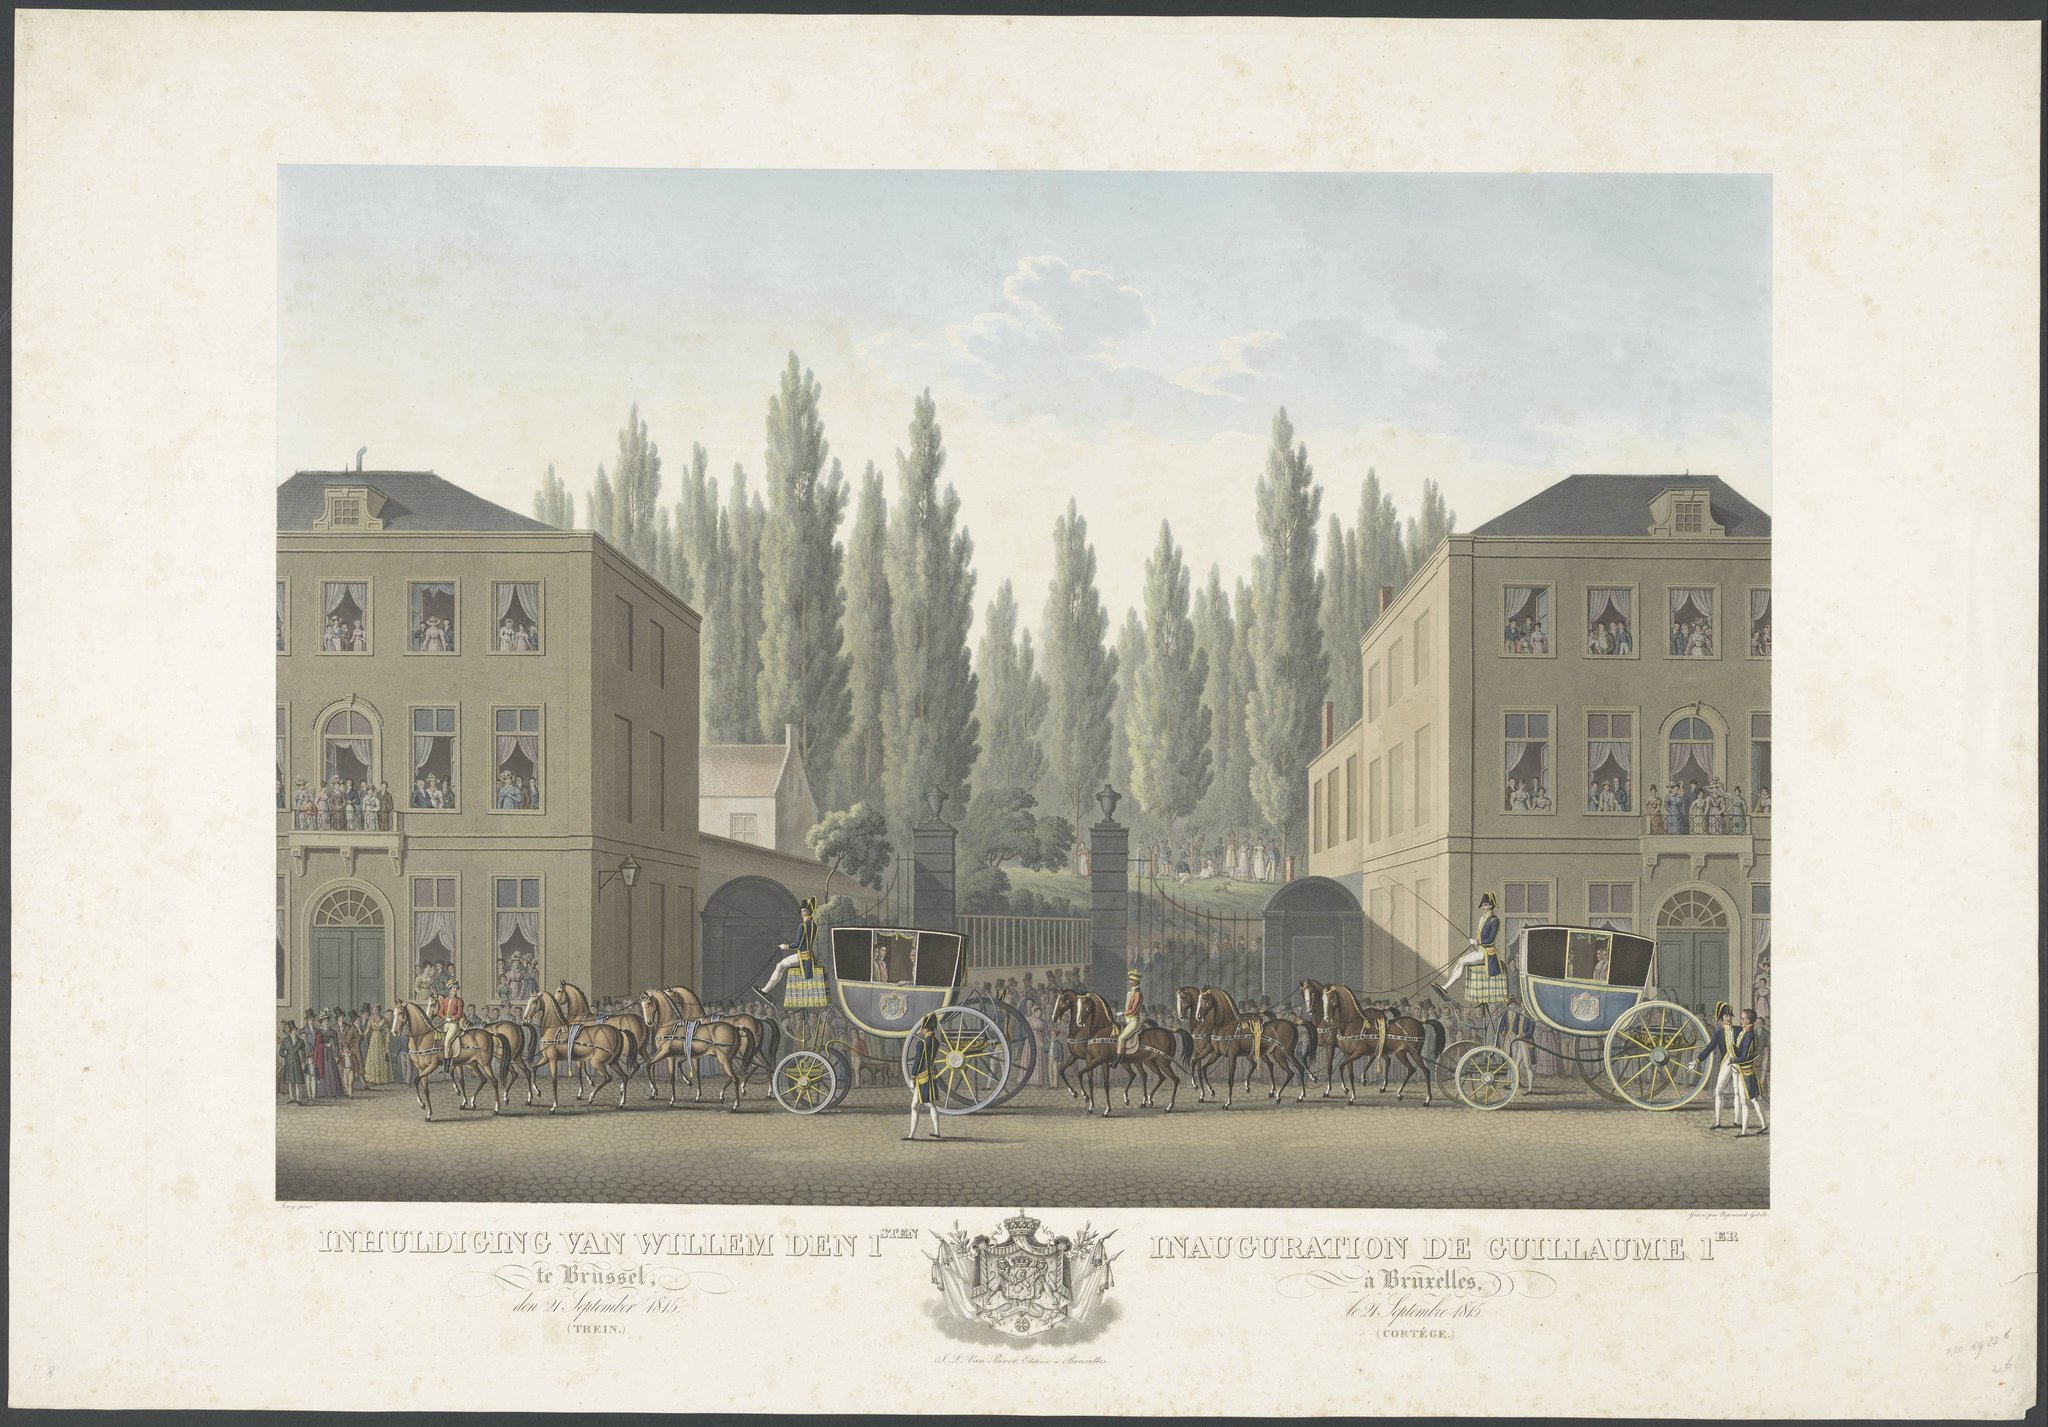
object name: history print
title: Inhuldiging van Willem den 1sten te Brussel, den 21 September 1815 (Trein.) / Inauguration de Guillaume 1er à Bruxelles, le 21 Septembre 1815. (Cortège.)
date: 1825-1826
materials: paper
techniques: aquatint, etching, hand coloring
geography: brussels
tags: the hague, berlin, william i of the netherlands, triumphal entry and public reception, pageant, 'entrée solennelle', 'joyeuse entrée', brussels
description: Plechtige intrede van de stoet voor de inhuldiging van koning Willem I te Brussel op 21 september 1815. Twee hofkoetsen, ieder met zes paarden. Onderaan de titels in het Nederlands en Frans gescheiden door het wapen van koning Willem I. Onderdeel van een serie platen van de aankomst en inhuldiging van Willem I in Brussel.